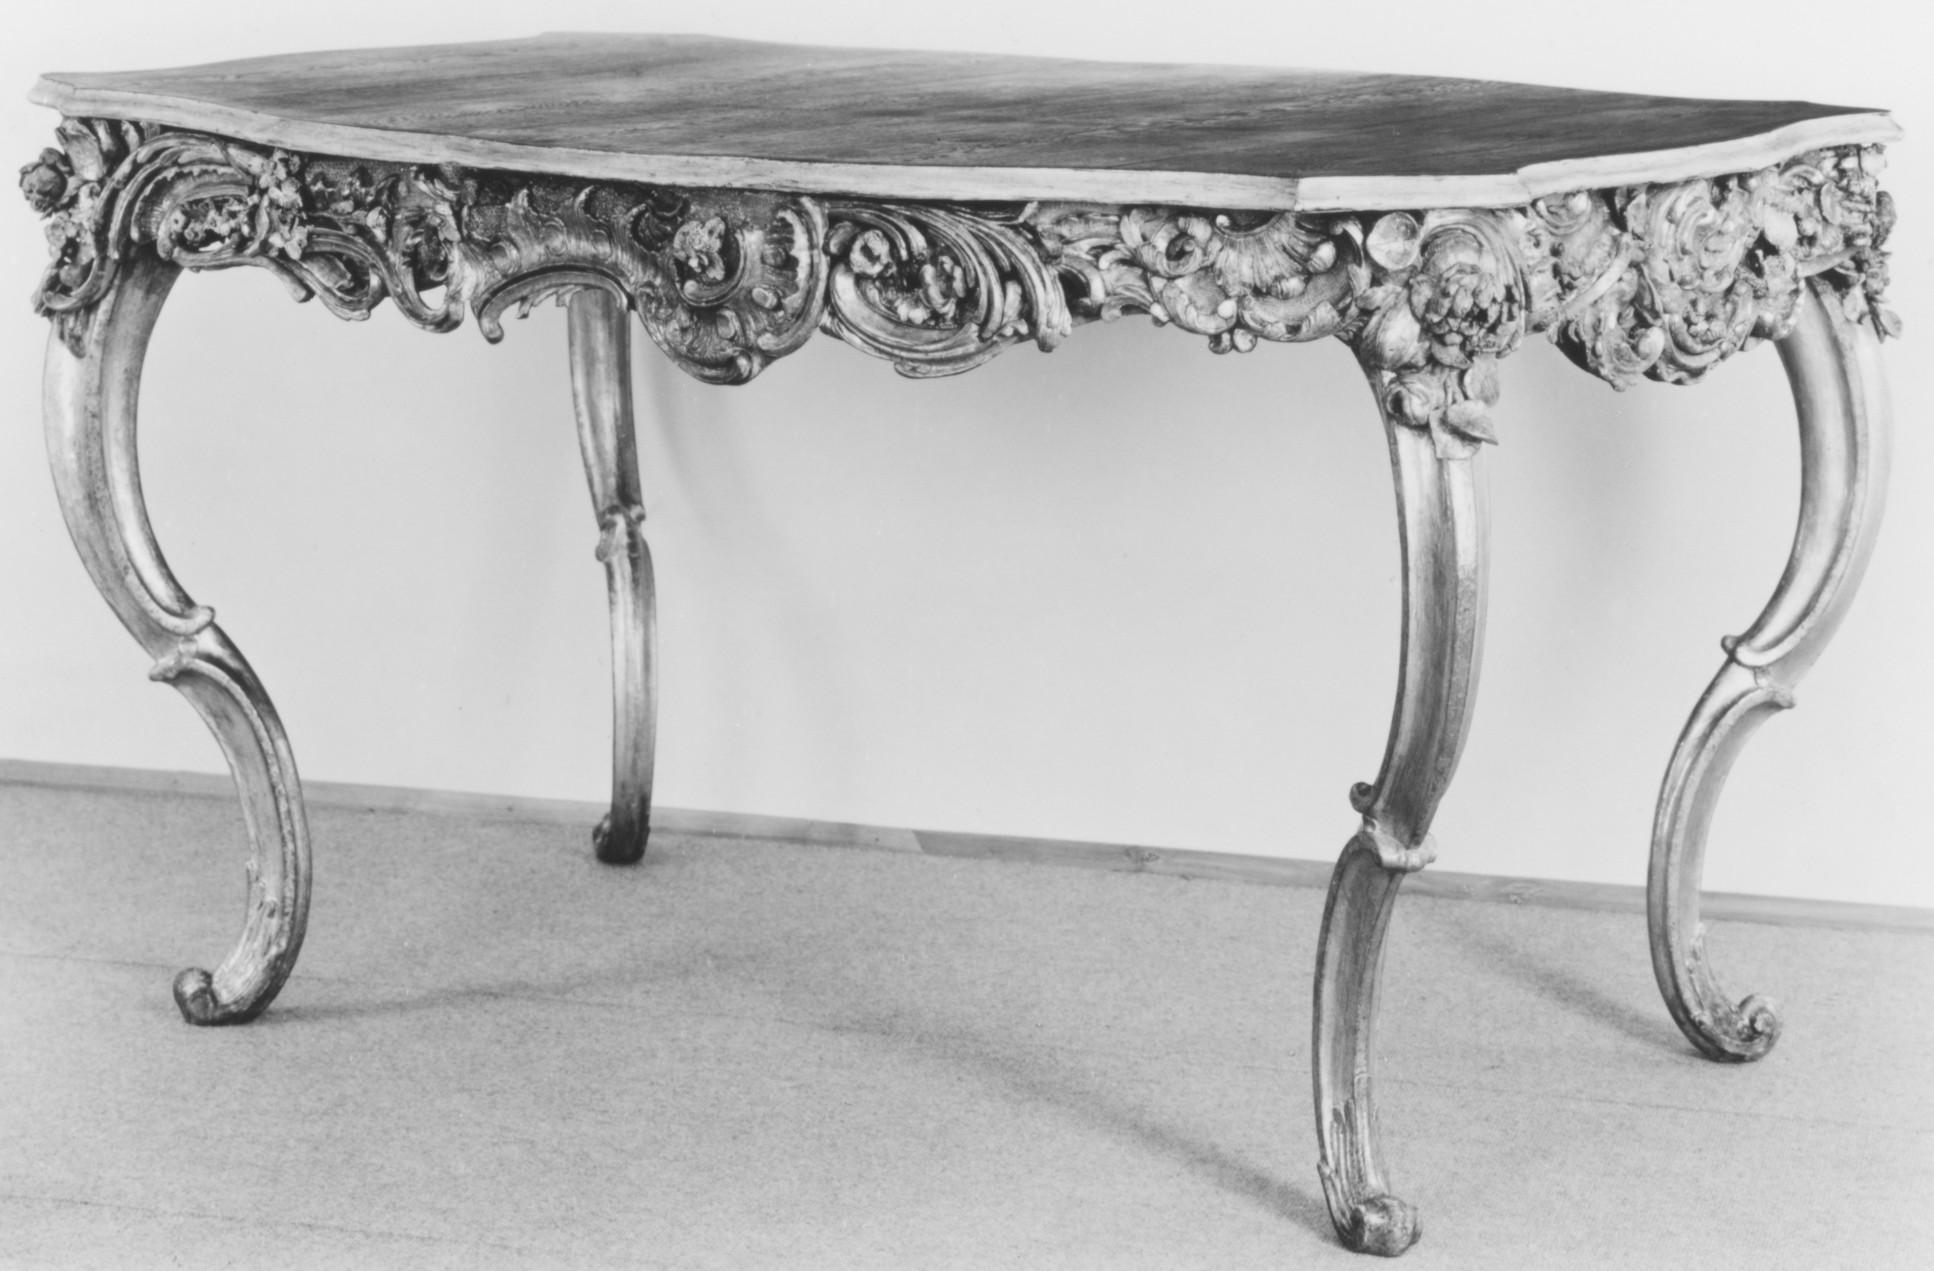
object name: center table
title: Center table (part of a set)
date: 1765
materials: wood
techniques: carving, gilding, painting